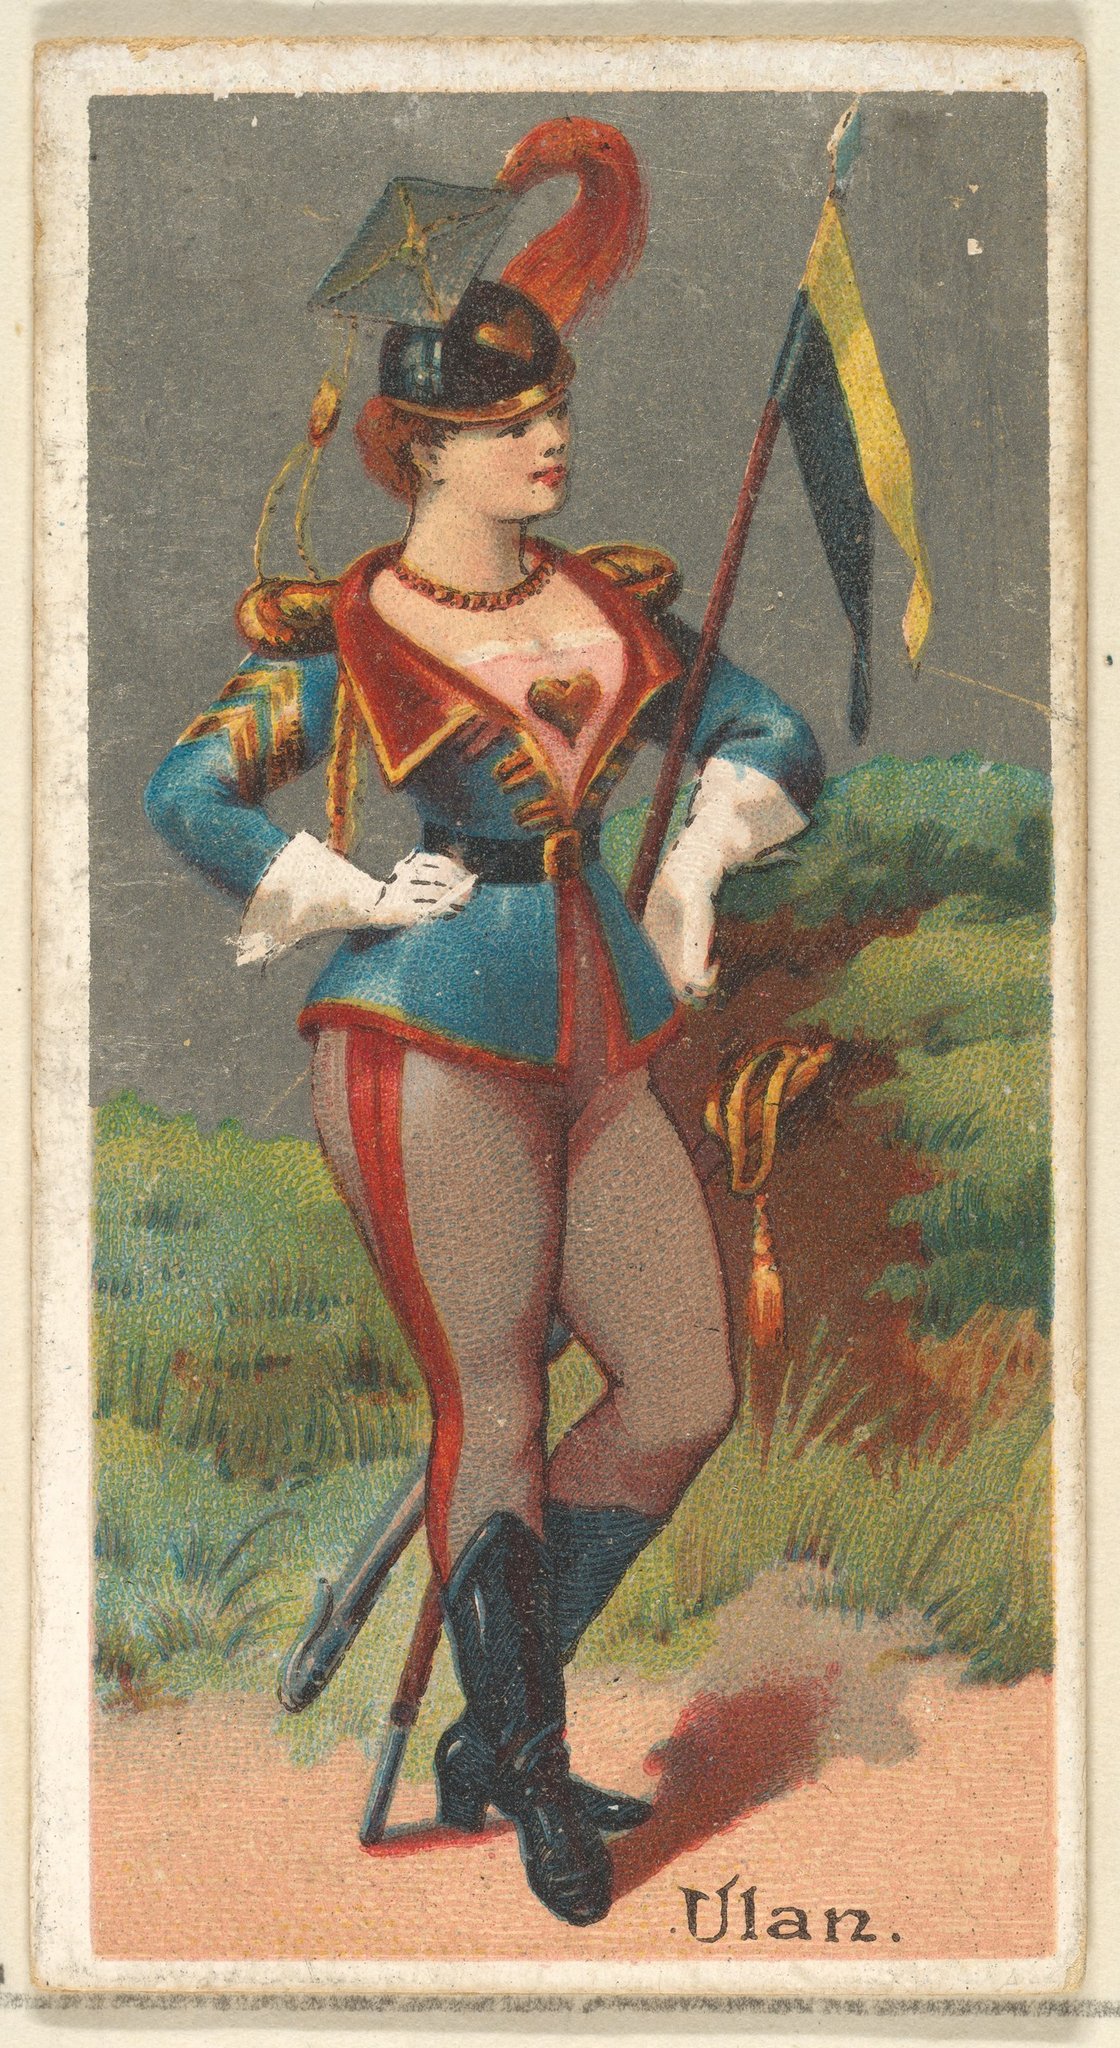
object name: print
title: Ulan, from the Occupations for Women series (N166) for Old Judge and Dogs Head Cigarettes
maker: goodwin & company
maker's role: publisher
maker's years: 1850-1950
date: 1887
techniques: color lithograph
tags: women